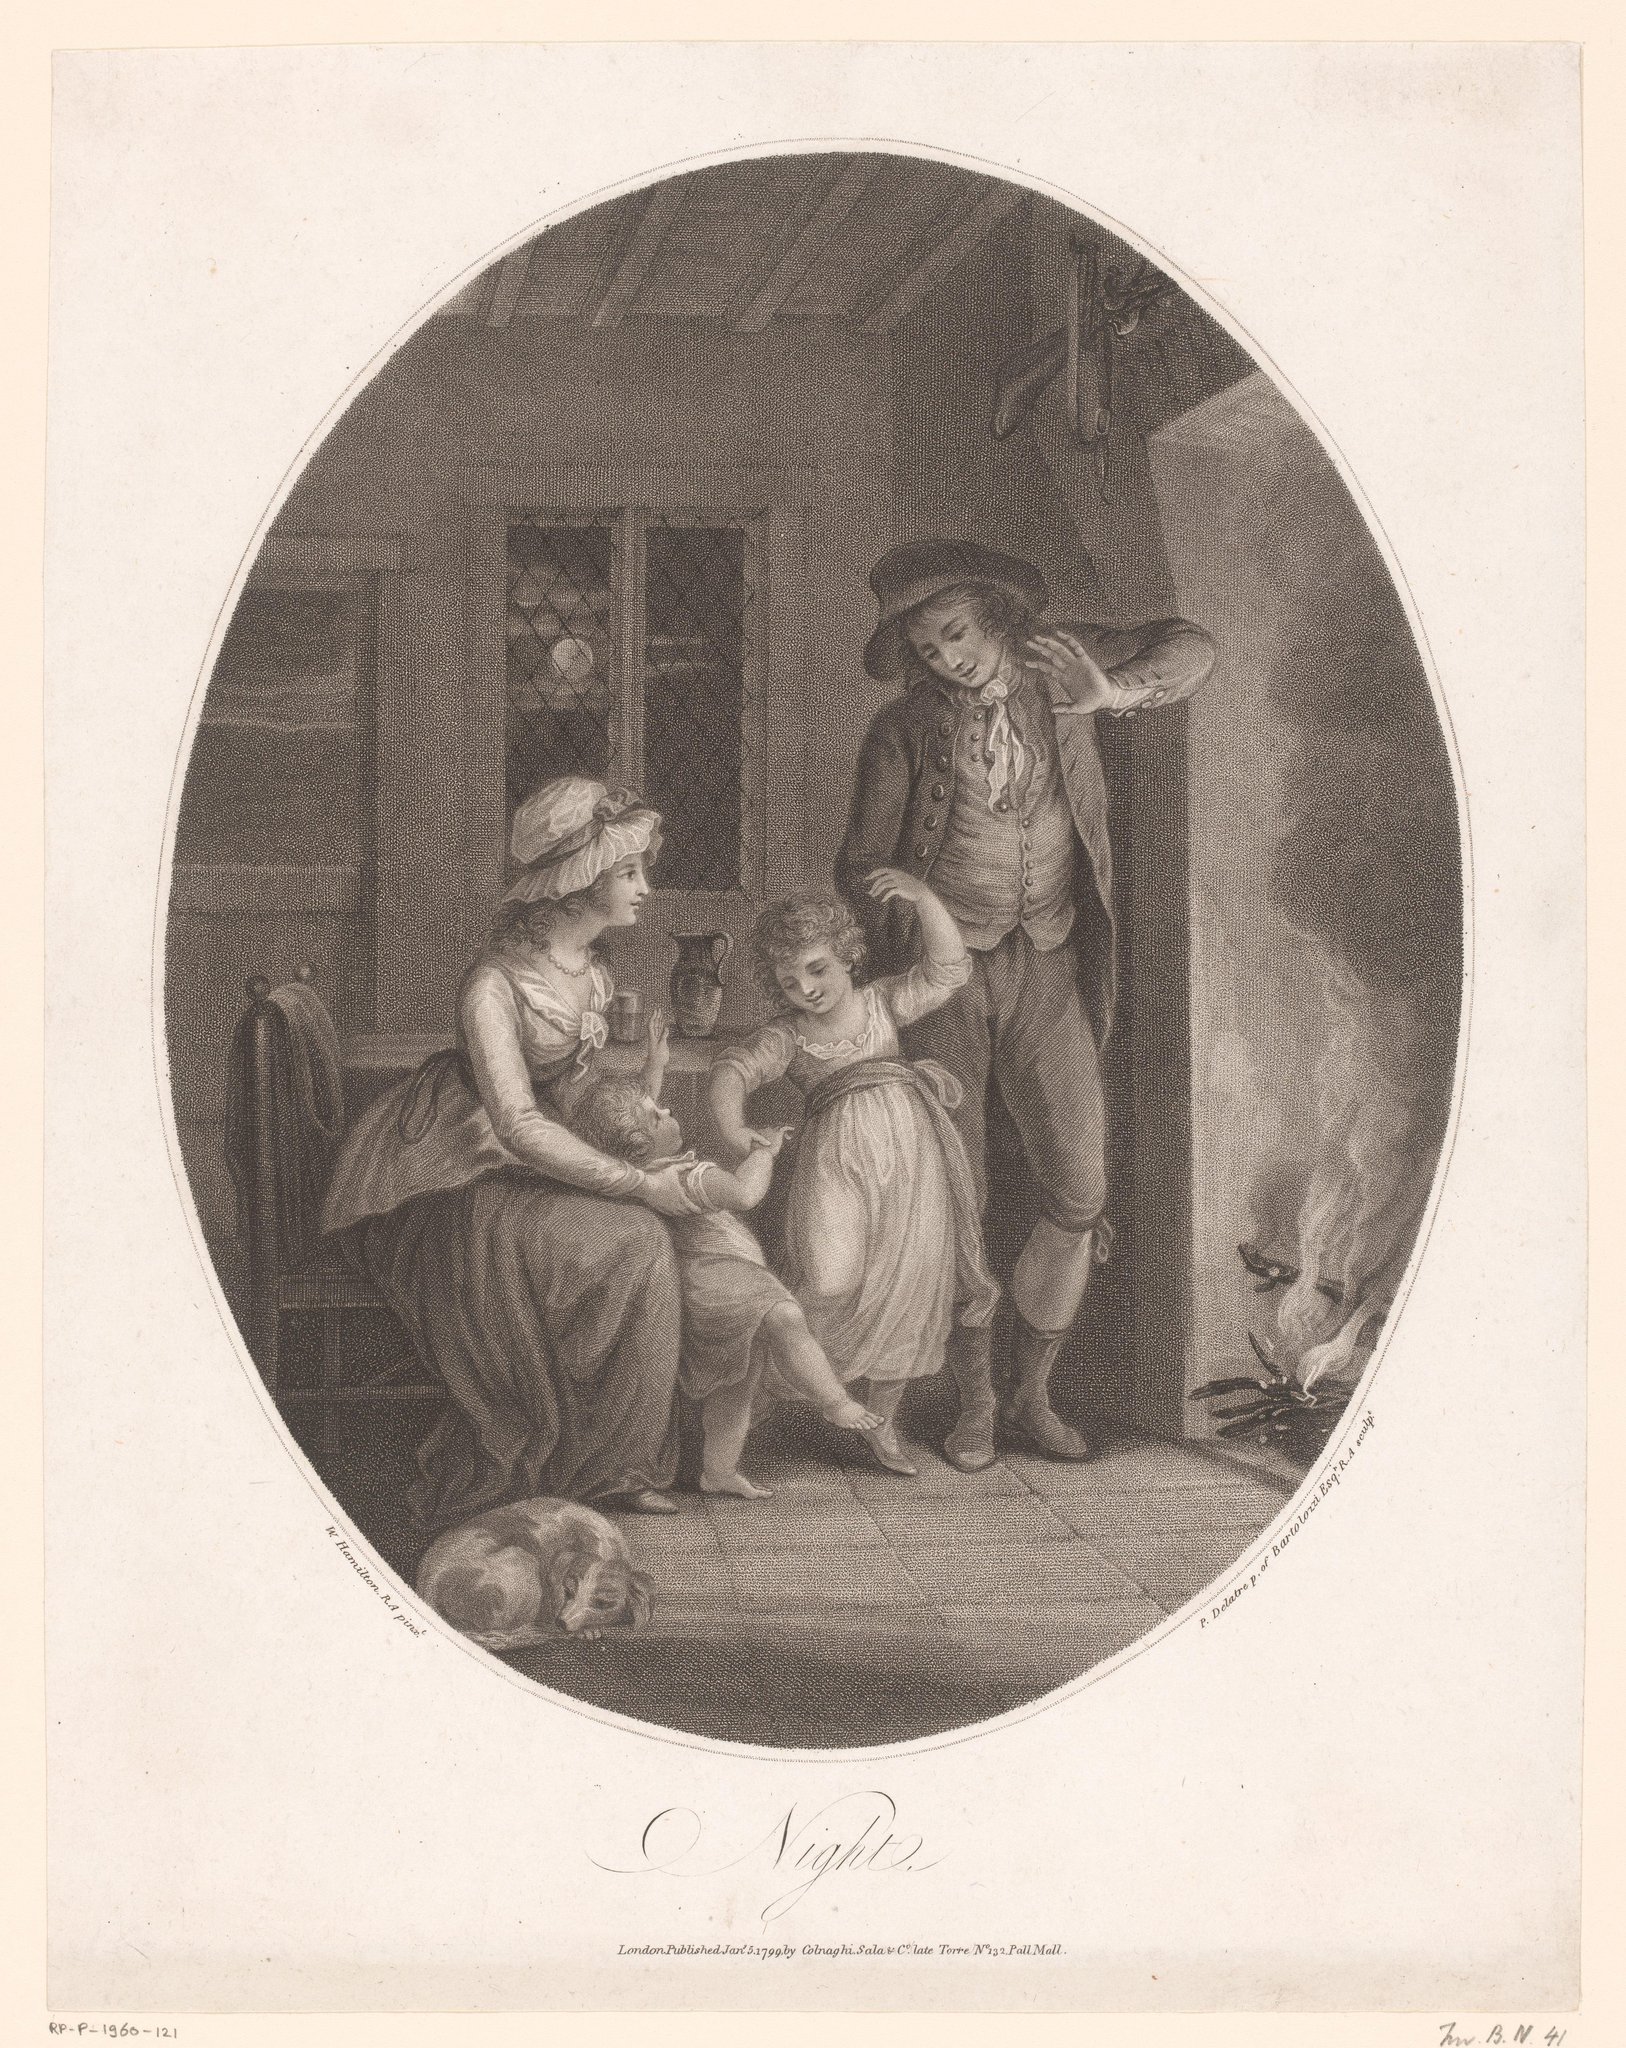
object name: print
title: De vier dagdelen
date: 1799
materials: paper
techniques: etching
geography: london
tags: full moon, open hearth, fire-place, interior of the house, family life at home, night, dog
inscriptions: collector's mark: Lugt 2760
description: Maakt deel uit van een serie van scènes met menselijke activiteiten gedurende de vier dagdelen.